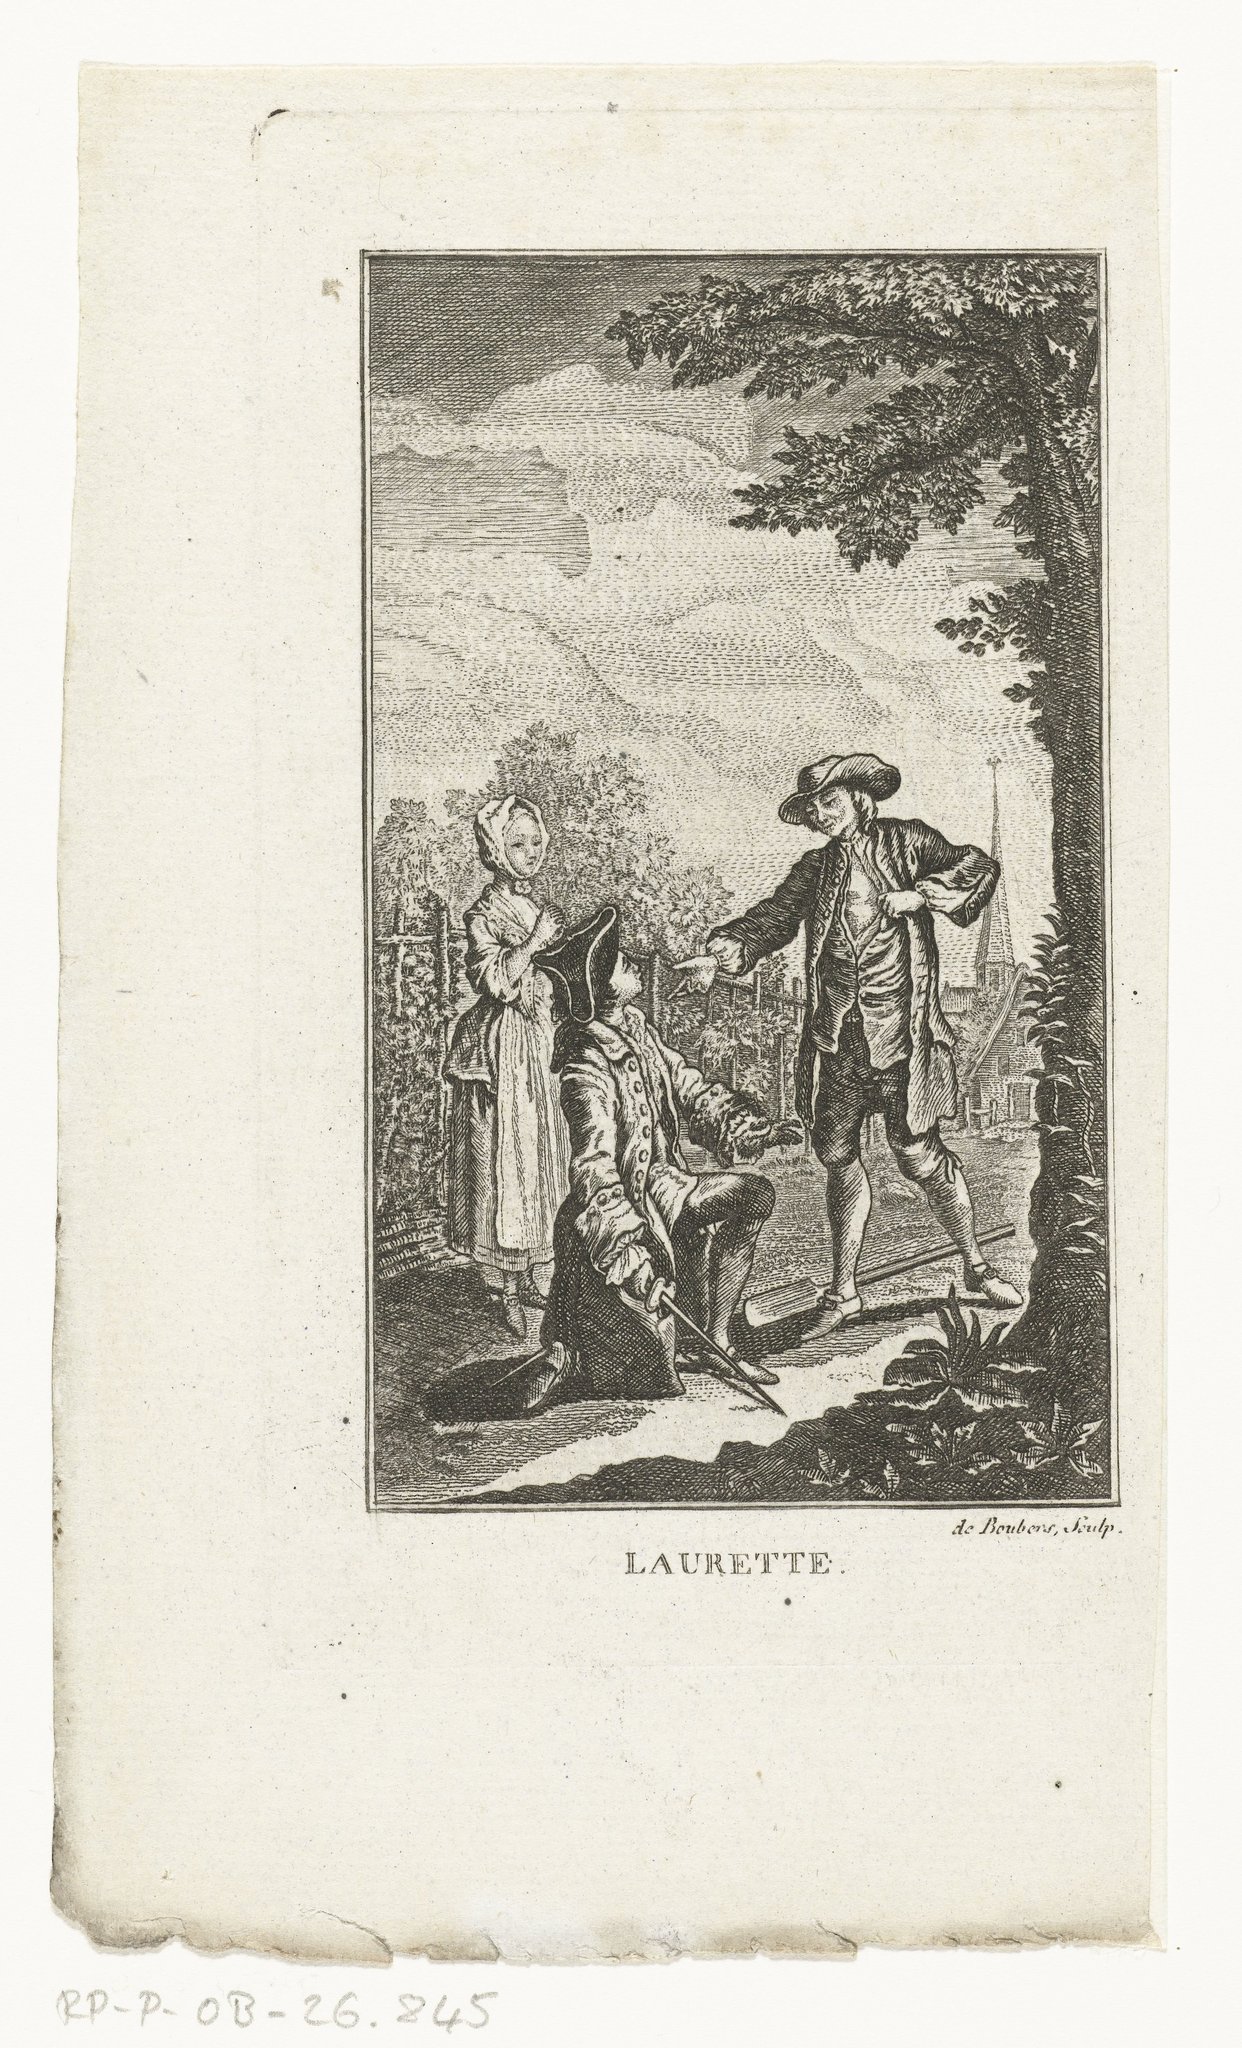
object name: print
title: Laurette en de graaf van Luzy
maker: n. de boubers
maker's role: print maker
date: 1765-1780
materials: paper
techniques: engraving, etching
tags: requesting the bride's parents' permission, married couple of unequal wealth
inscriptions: collector's mark: Lugt 2228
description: Illustratie voor het verhaal 'Laurette' uit J.F. Marmontel's verhalenbundel 'Contes moreaux'. De arme maar beeldschone boerendochter Laurette danst bij een dorpsfeest met de graaf van Luzy. Hij wordt opslag verliefd op het meisje en vraagt haar vader om haar hand. De graaf knielt neer voor de boer, Laurette staat naast hen.